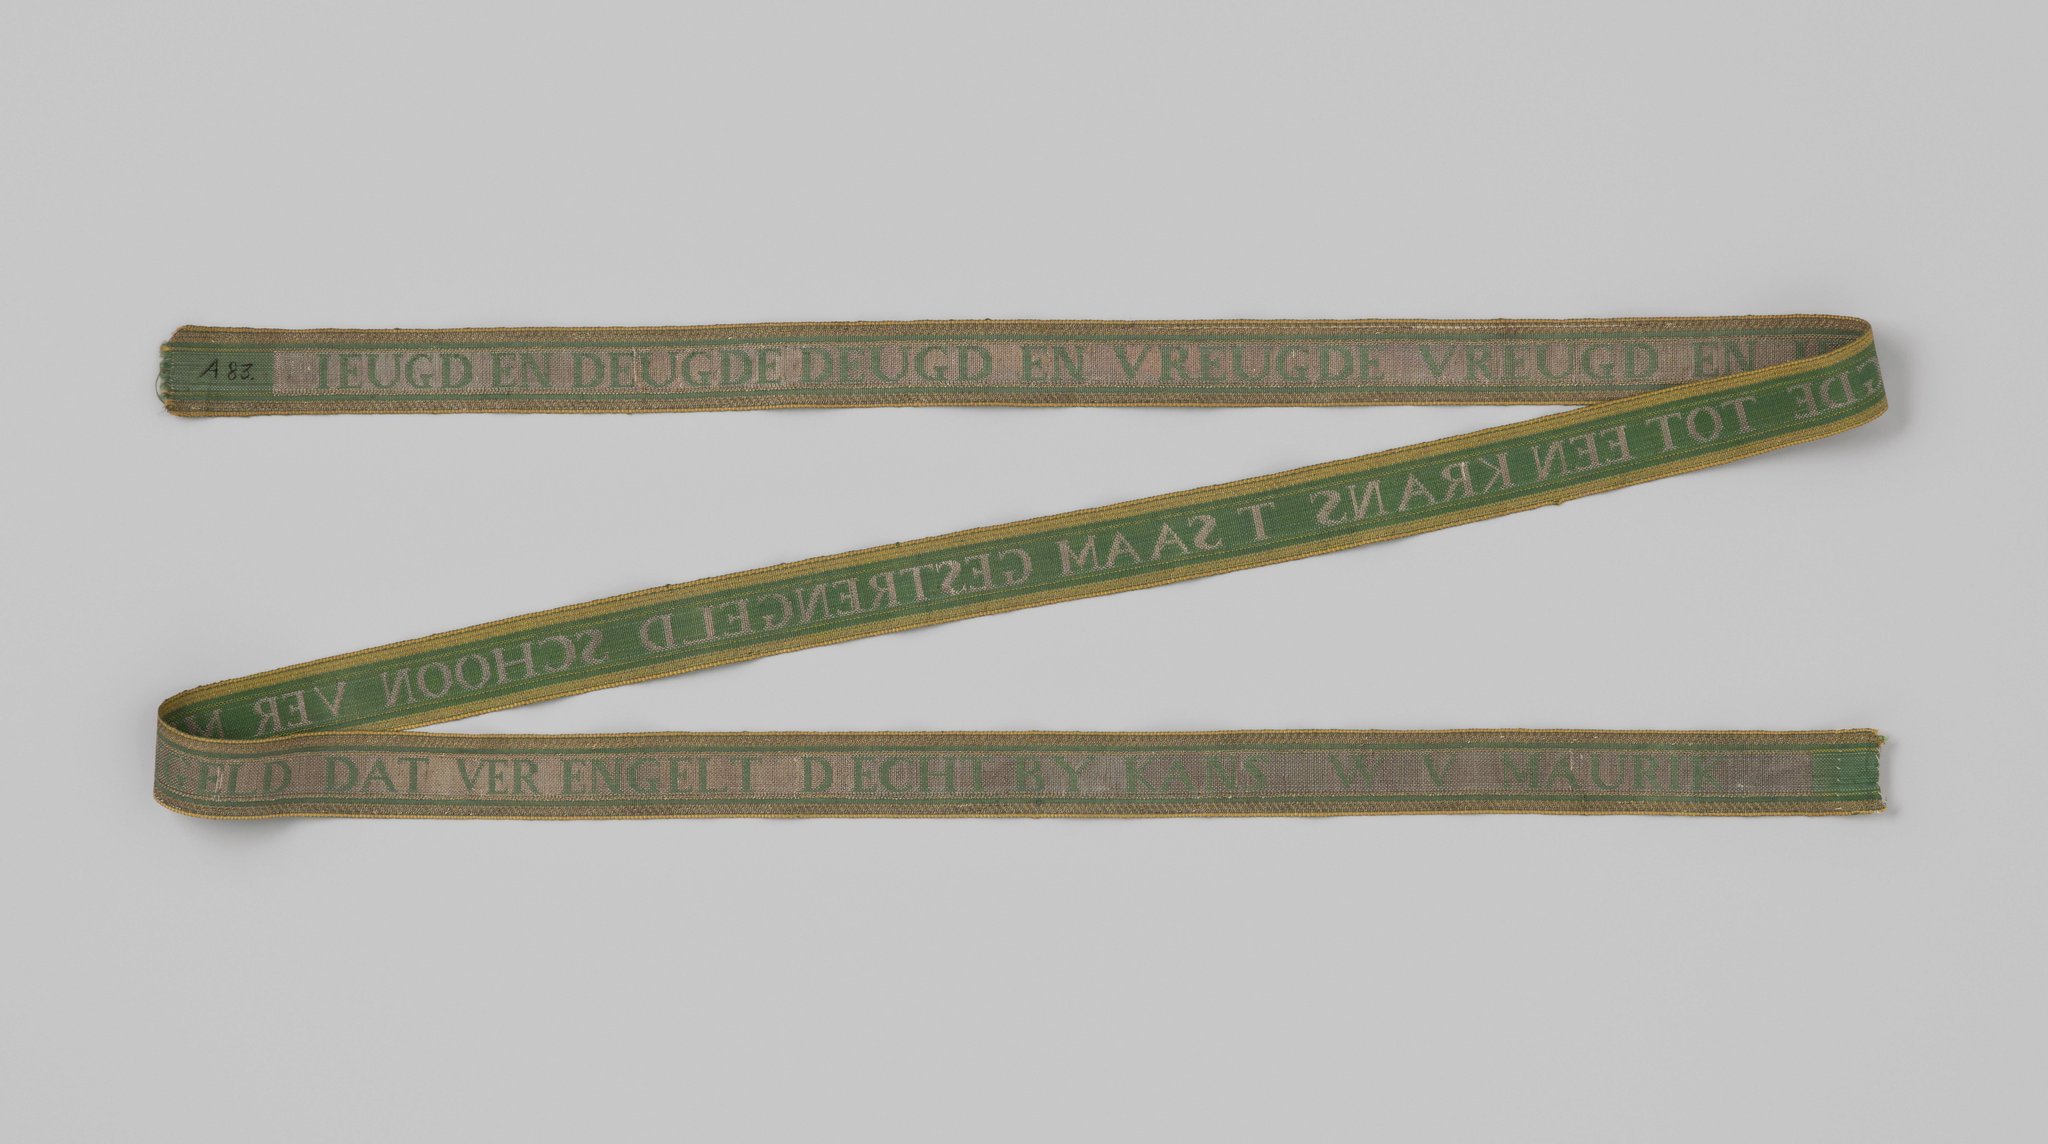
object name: clothing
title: Kousenband van groene zijde doorweven met zilverdraad; met de tekst: 'IEUDG EN DEUGDE DEUGD EN VREUGDE VREUGD EN IEUGDE TOT EEN KRANS T SAAM GESTRENGELD SCHOON VER MENGELD DAT VER ENGELT D ECHT BY KANS W V MAURIK'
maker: Anonymous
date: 1877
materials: silk, thread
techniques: weave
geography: netherlands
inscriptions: inscription: ‘IEUDG EN DEUGDE DEUGD EN VREUGDE VREUGD EN IEUGDE TOT EEN KRANS T SAAM GESTRENGELD SCHOON VER MENGELD DAT VER ENGELT D ECHT BY KANS W V MAURIK’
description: Kousenband van groene zijde doorweven met zilverdraad. In de lengte is het opschrift 'IEUDG EN DEUGDE DEUGD EN VREUGDE VREUGD EN IEUGDE TOT EEN KRANS T SAAM GESTRENGELD SCHOON VER MENGELD DAT VER ENGELT D ECHT BY KANS W V MAURIK' te lezen.